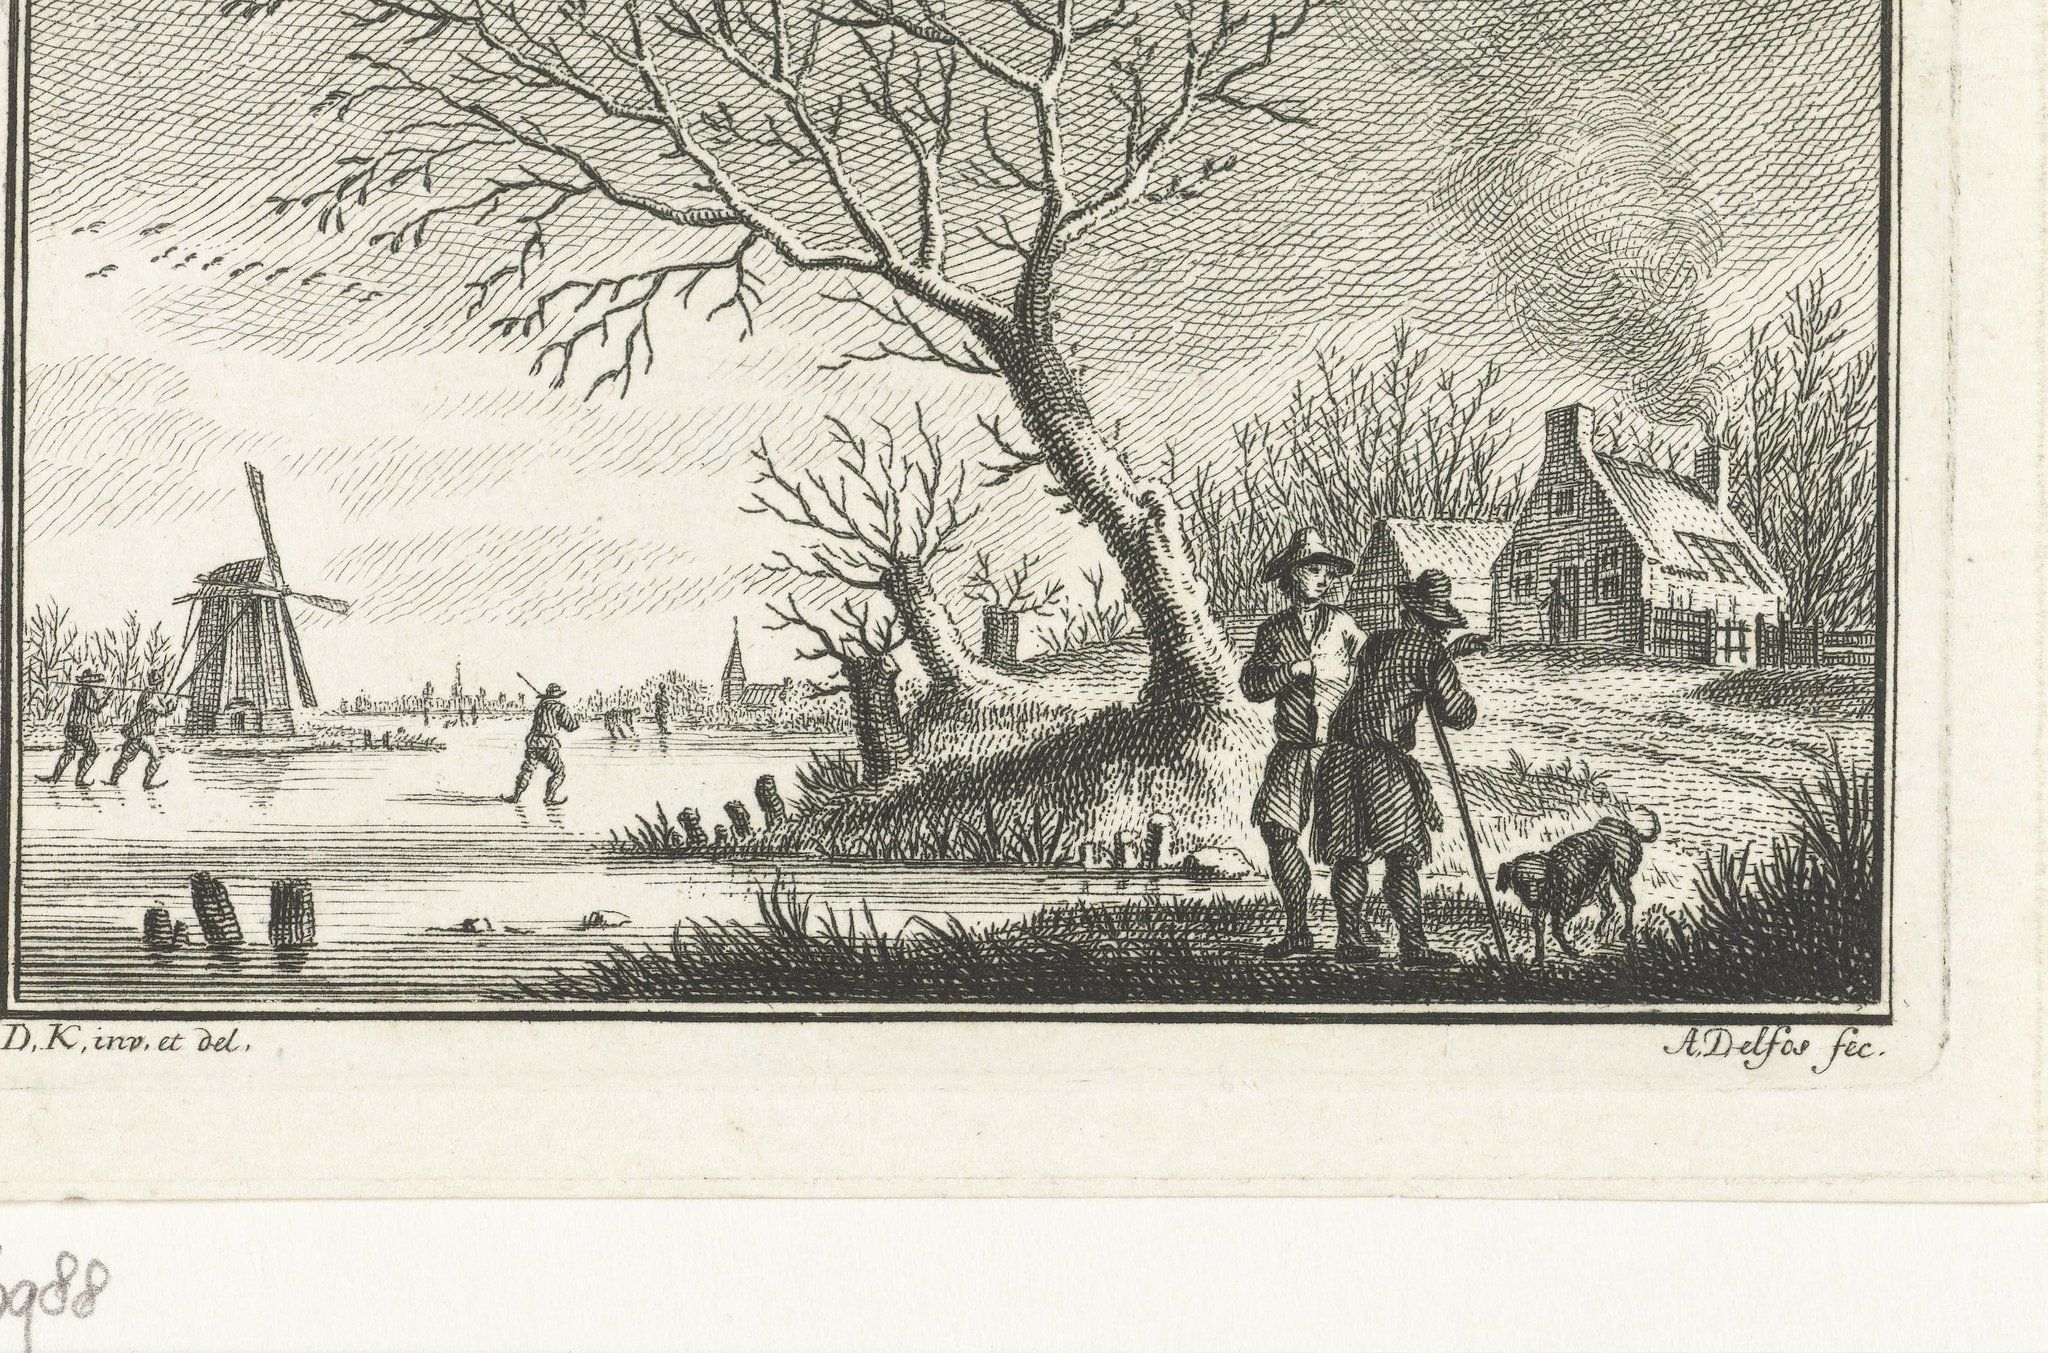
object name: print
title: Winterlandschap met schaatsers op het ijs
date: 1764-1765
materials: paper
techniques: etching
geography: leiden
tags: (high) hill, skates (winter sports)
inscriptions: collector's mark: Lugt 240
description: Prent gebruikt voor: Dirk Kuipers, Dichtlievende mengelingen, Leiden, Wed. A. Honkoop en Zoon & C. van Hoogeveen Jr., 1764-1765, p. 49